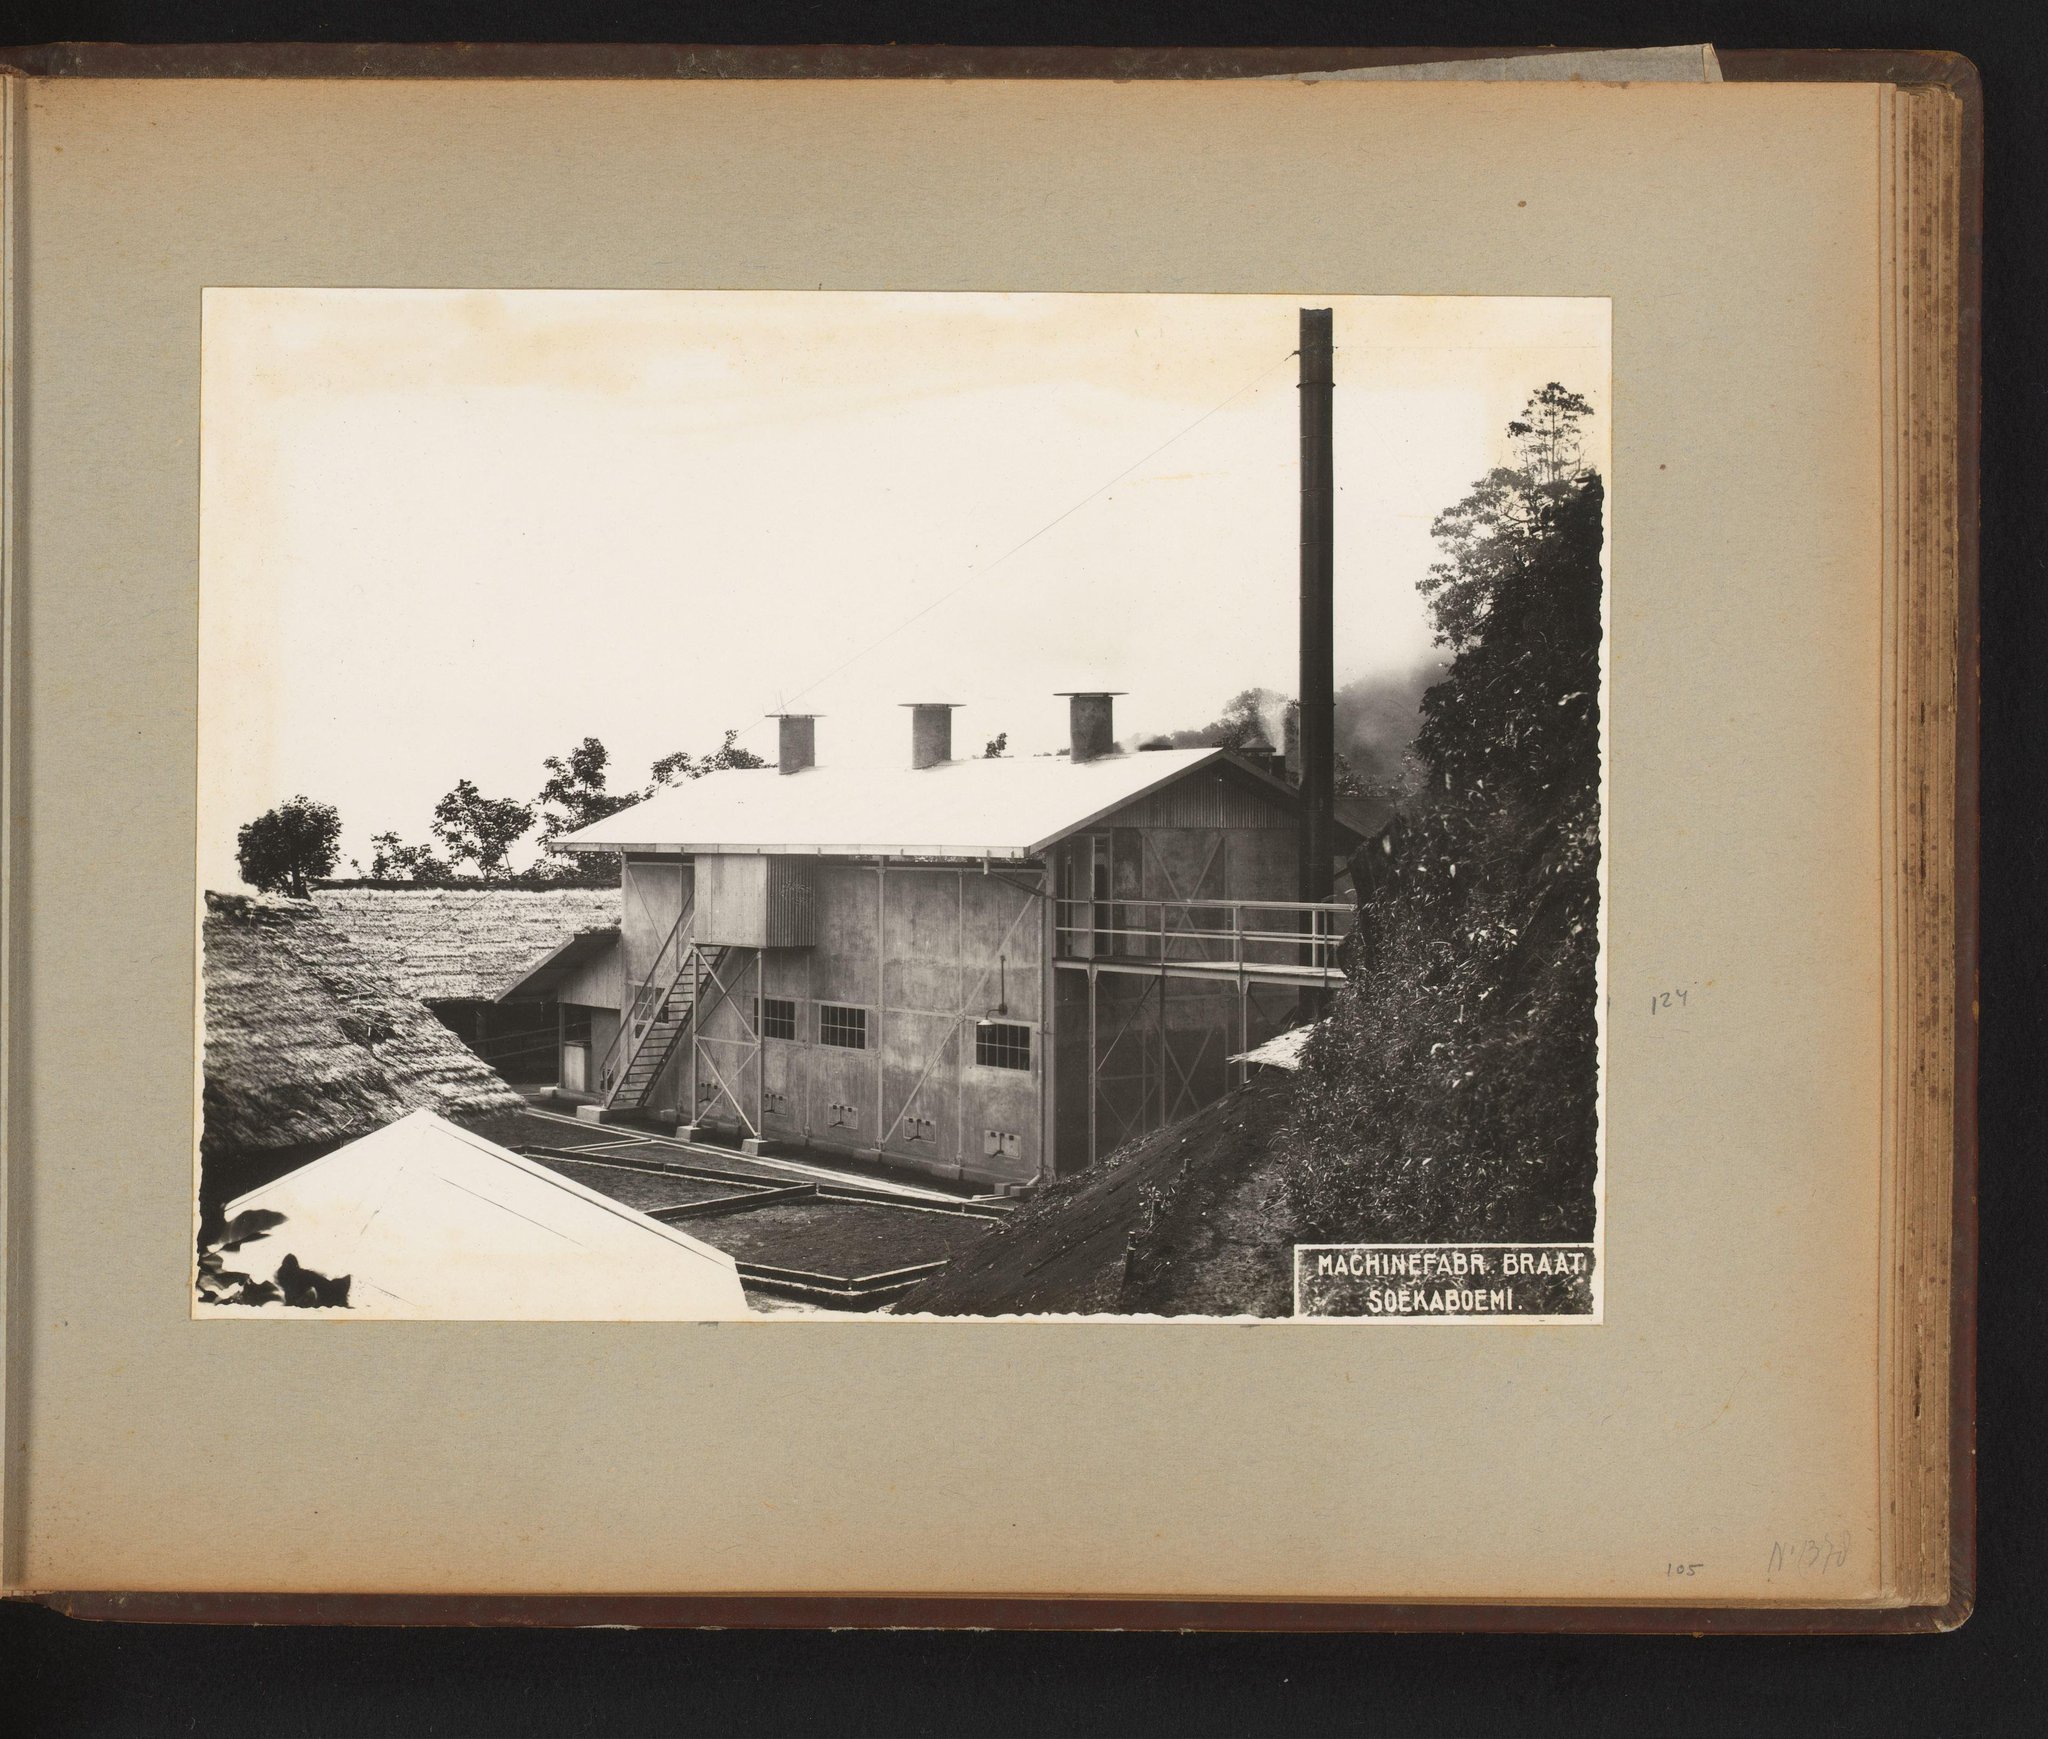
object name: photograph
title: Kinaonderneming Daradjat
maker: Anonymous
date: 1935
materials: cardboard, photographic support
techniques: gelatin silver print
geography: west java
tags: factory-building, java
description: Albumblad met een foto van een gebouw van de kina-onderneming Daradjat, gebouwd in 1935 door Braat Soekaboemi. Onderdeel van een fotoalbum met foto's van machines en constructies van de N.V. Machinefabriek Braat te Soerabaja, Soekaboemi en Tegal uit de periode 1931-1937.